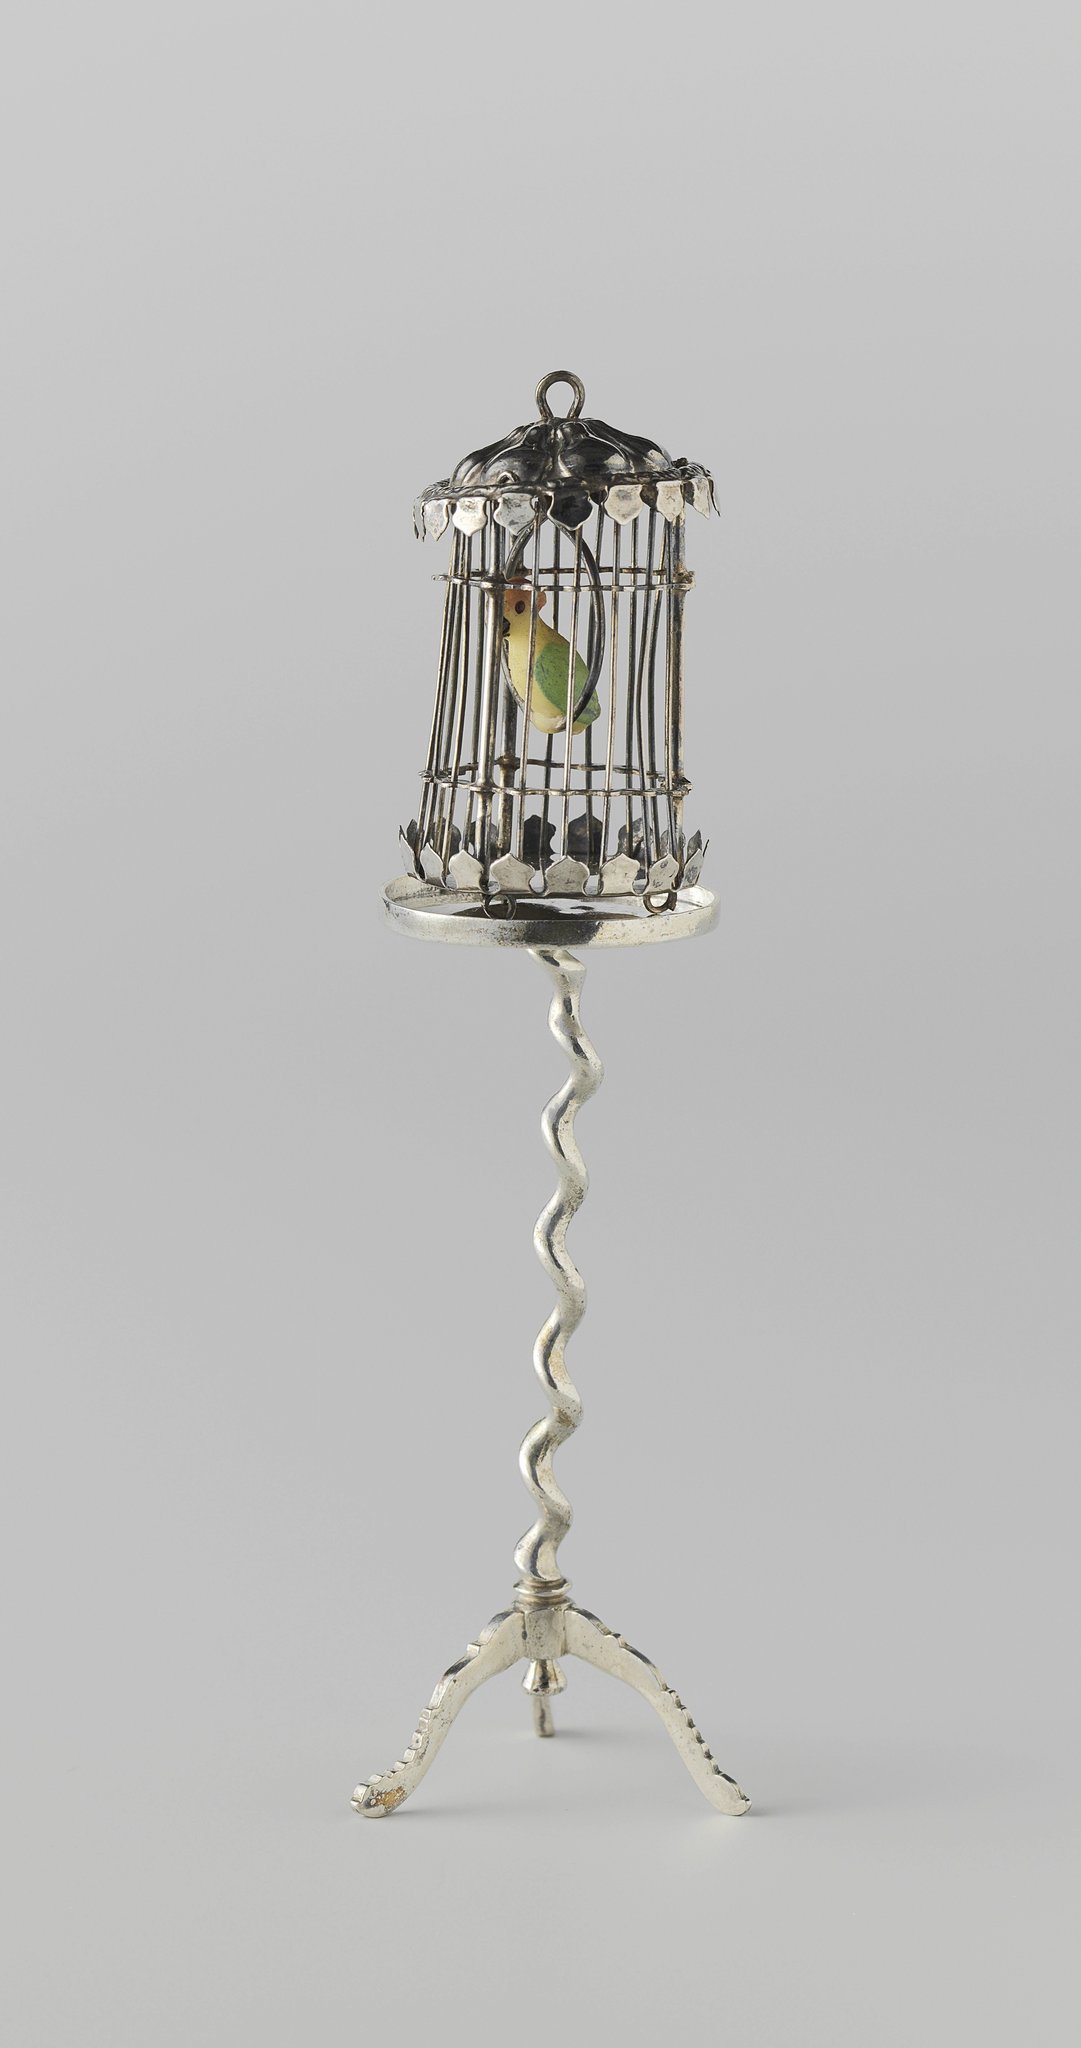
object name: miniature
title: Guéridon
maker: pieter van somerwil (i)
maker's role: silversmith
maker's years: 1706-1753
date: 1759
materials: silver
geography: amsterdam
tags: bird in a cage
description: Ronde guéridon op een hoge gedraaide poot die onderaan uitloopt in een driepoot. De guéridon is gemerkt: stk.= Amsterdam, jrl.= Z (1759) en mt.= Pieter van Somerwil I. Op de guéridon staat een vogelkooi (BK-NM-11177-155-a).